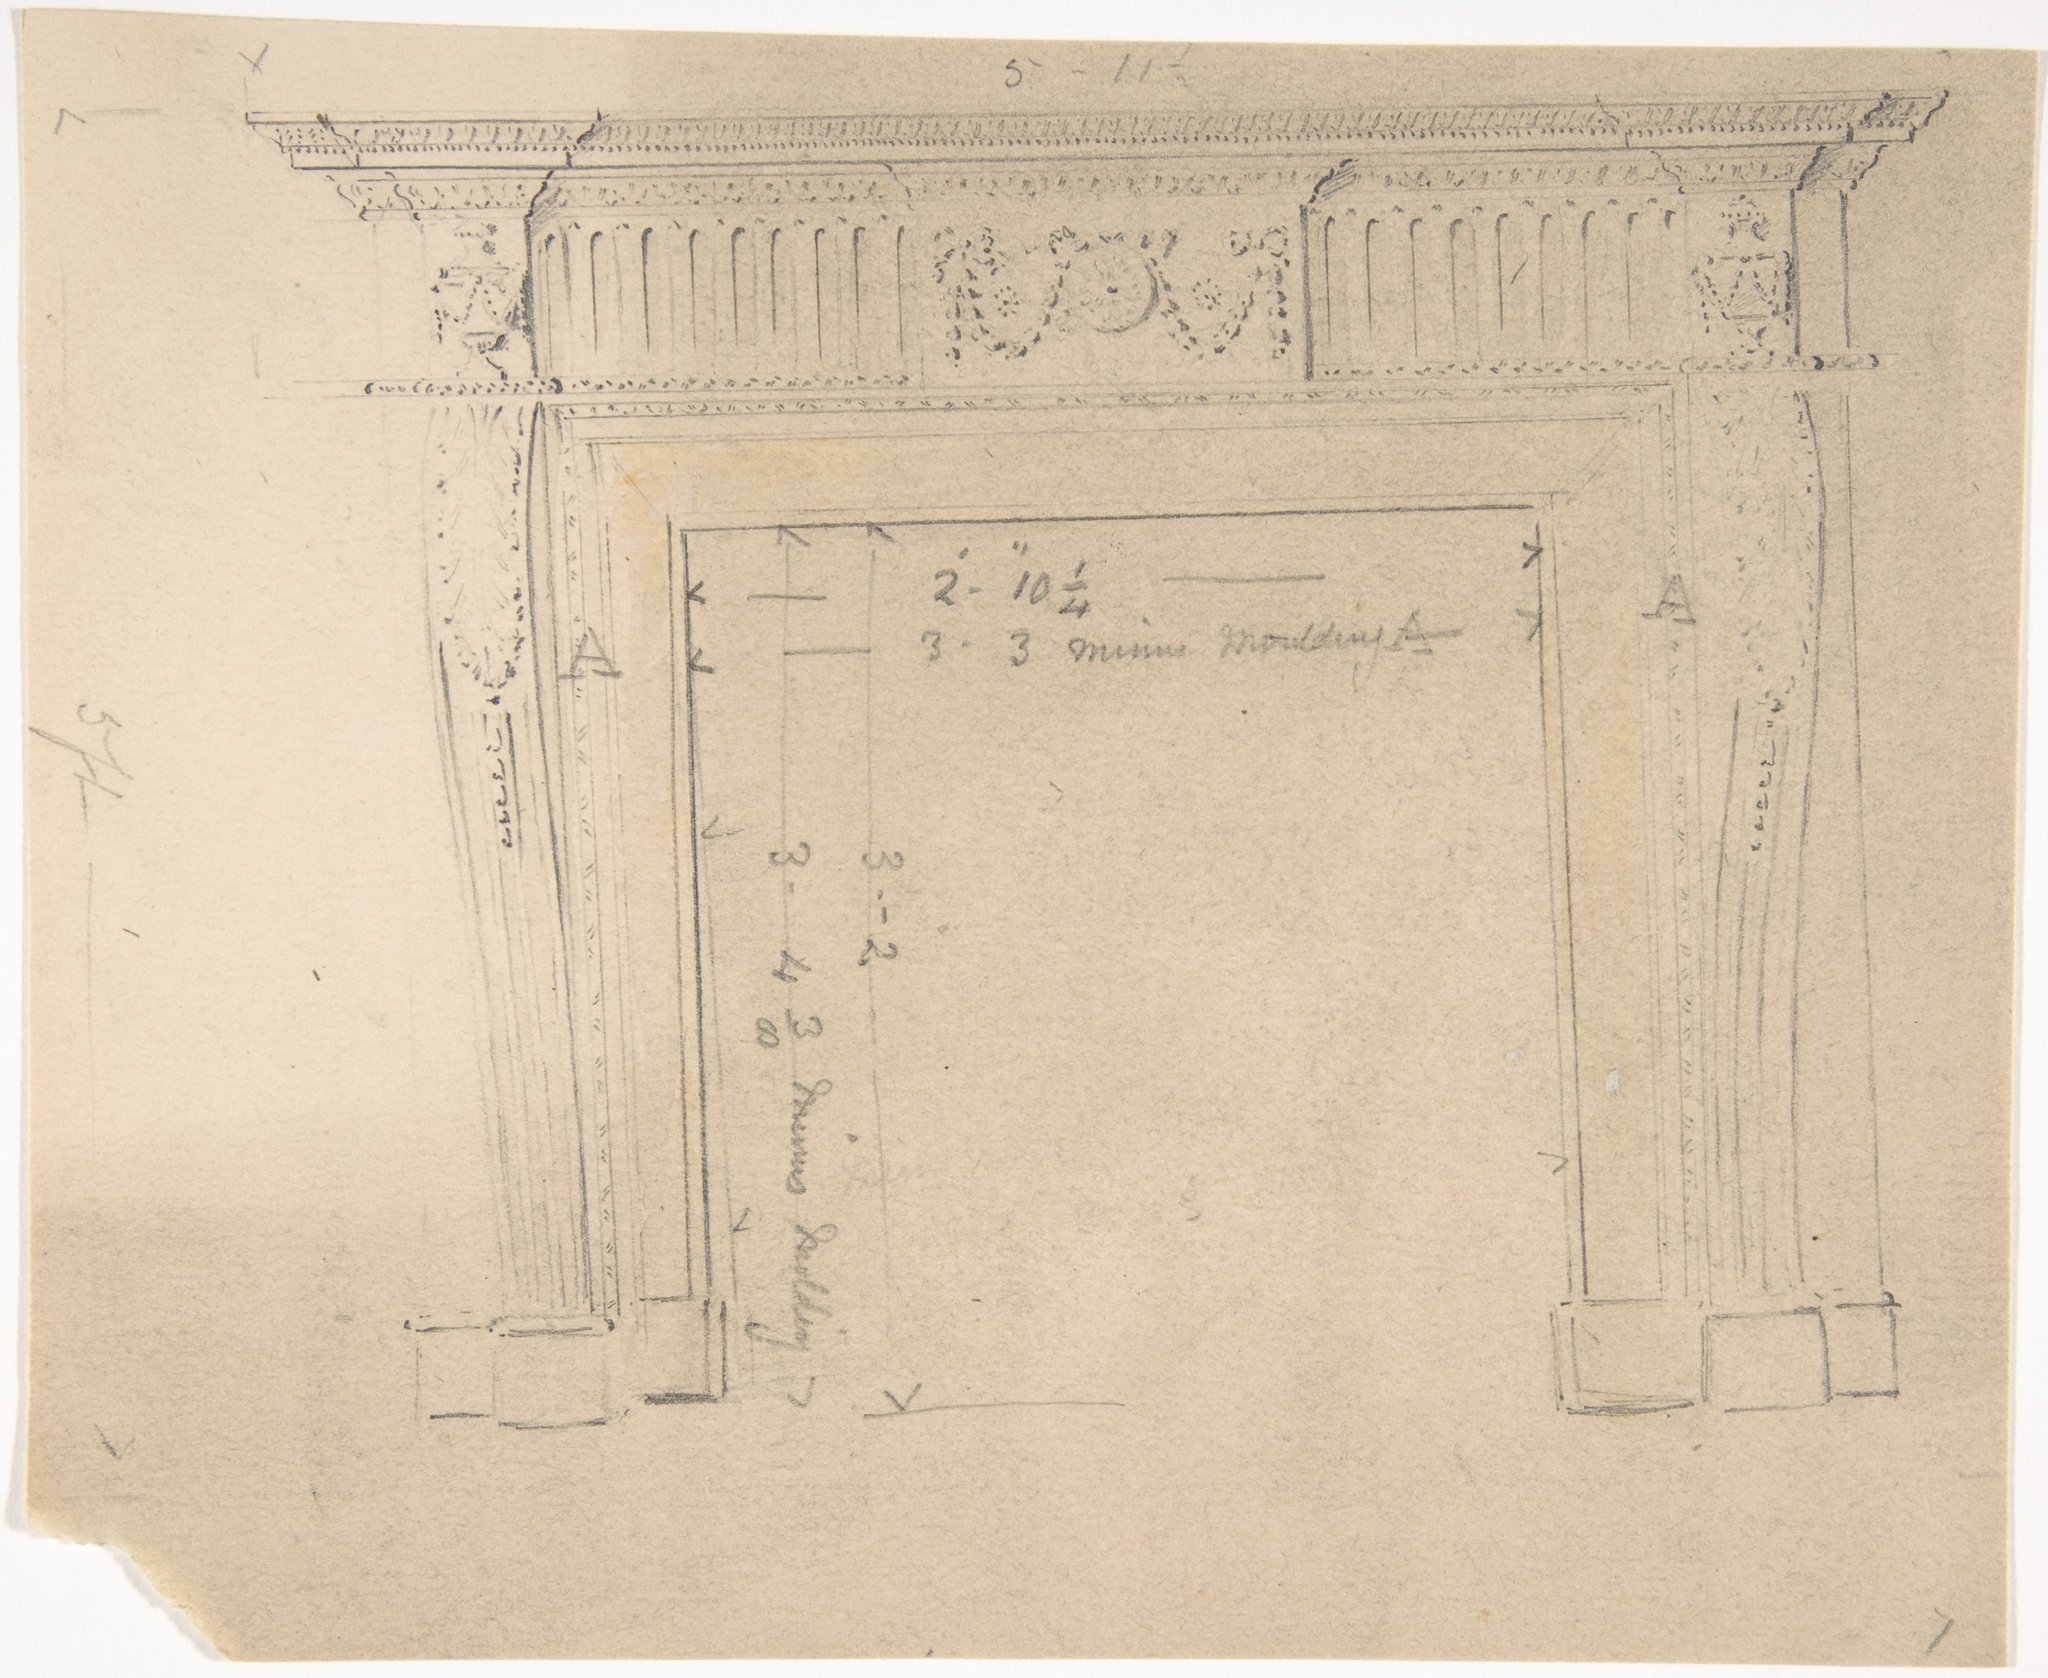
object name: drawing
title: Design for a Fireplace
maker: anonymous, british, 19th century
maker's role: artist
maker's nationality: british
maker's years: 1800-1900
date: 1801-1850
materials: graphite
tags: fireplaces,garlands